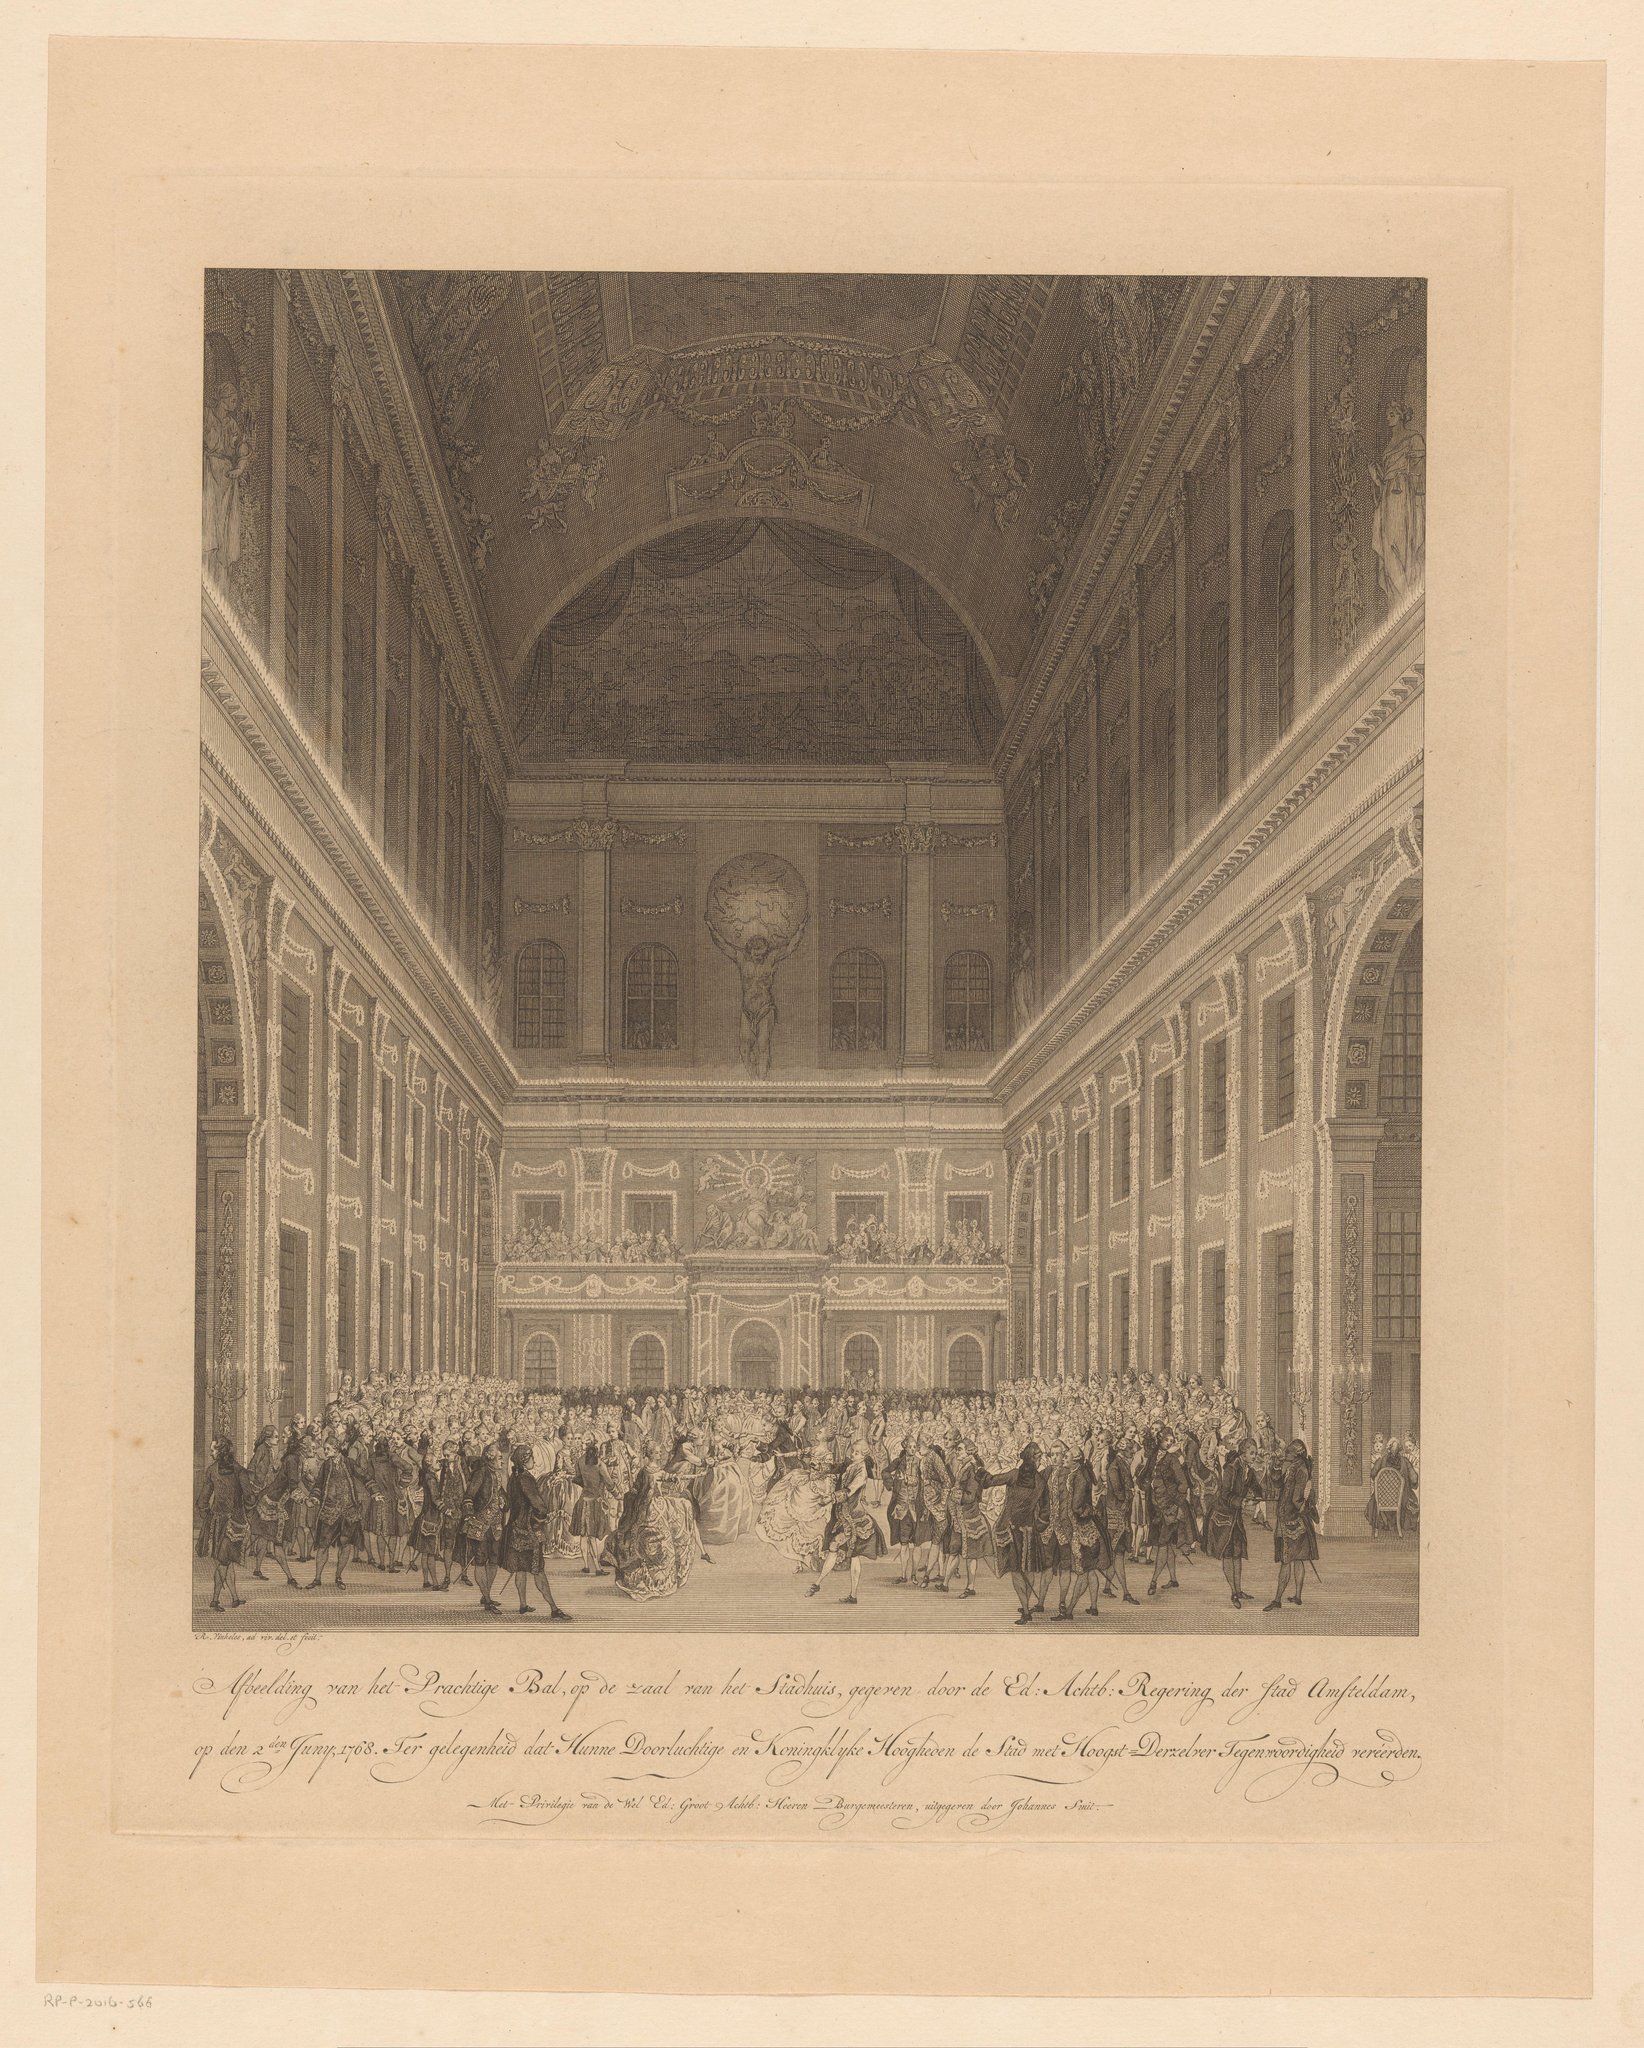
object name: print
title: Afbeelding van het prachtige bal, op de zaal van het Stadhuis, gegeven door de ed: achtb: Regering der stad Amsterdam, op den 2den juny, 1768 (...)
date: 1772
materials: paper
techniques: engraving, etching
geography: amsterdam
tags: the hague, william v (prince of orange), berlin, painter, wilhelmina of prussia (princess of orange), public festivities on the occasion of royal events (+ dancing ~ festive activities), ball, formal dance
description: Het bal in de Burgerzaal van het Amsterdamse stadhuis gegeven door het stadsbestuur ter gelegenheid van het bezoek van stadhouder Willem V en prinses Wilhelmina van Pruisen, 2 juni 1768.